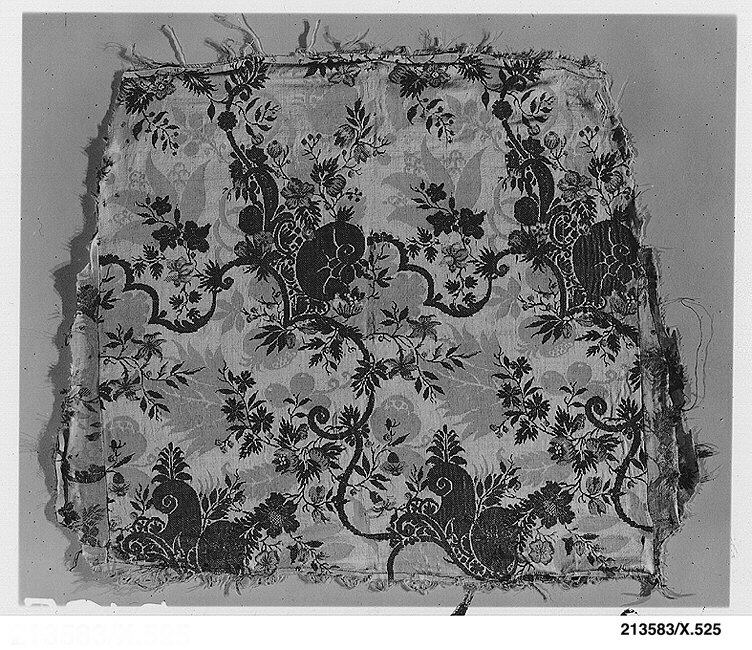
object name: piece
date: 1701-1800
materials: silk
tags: flowers,leaves